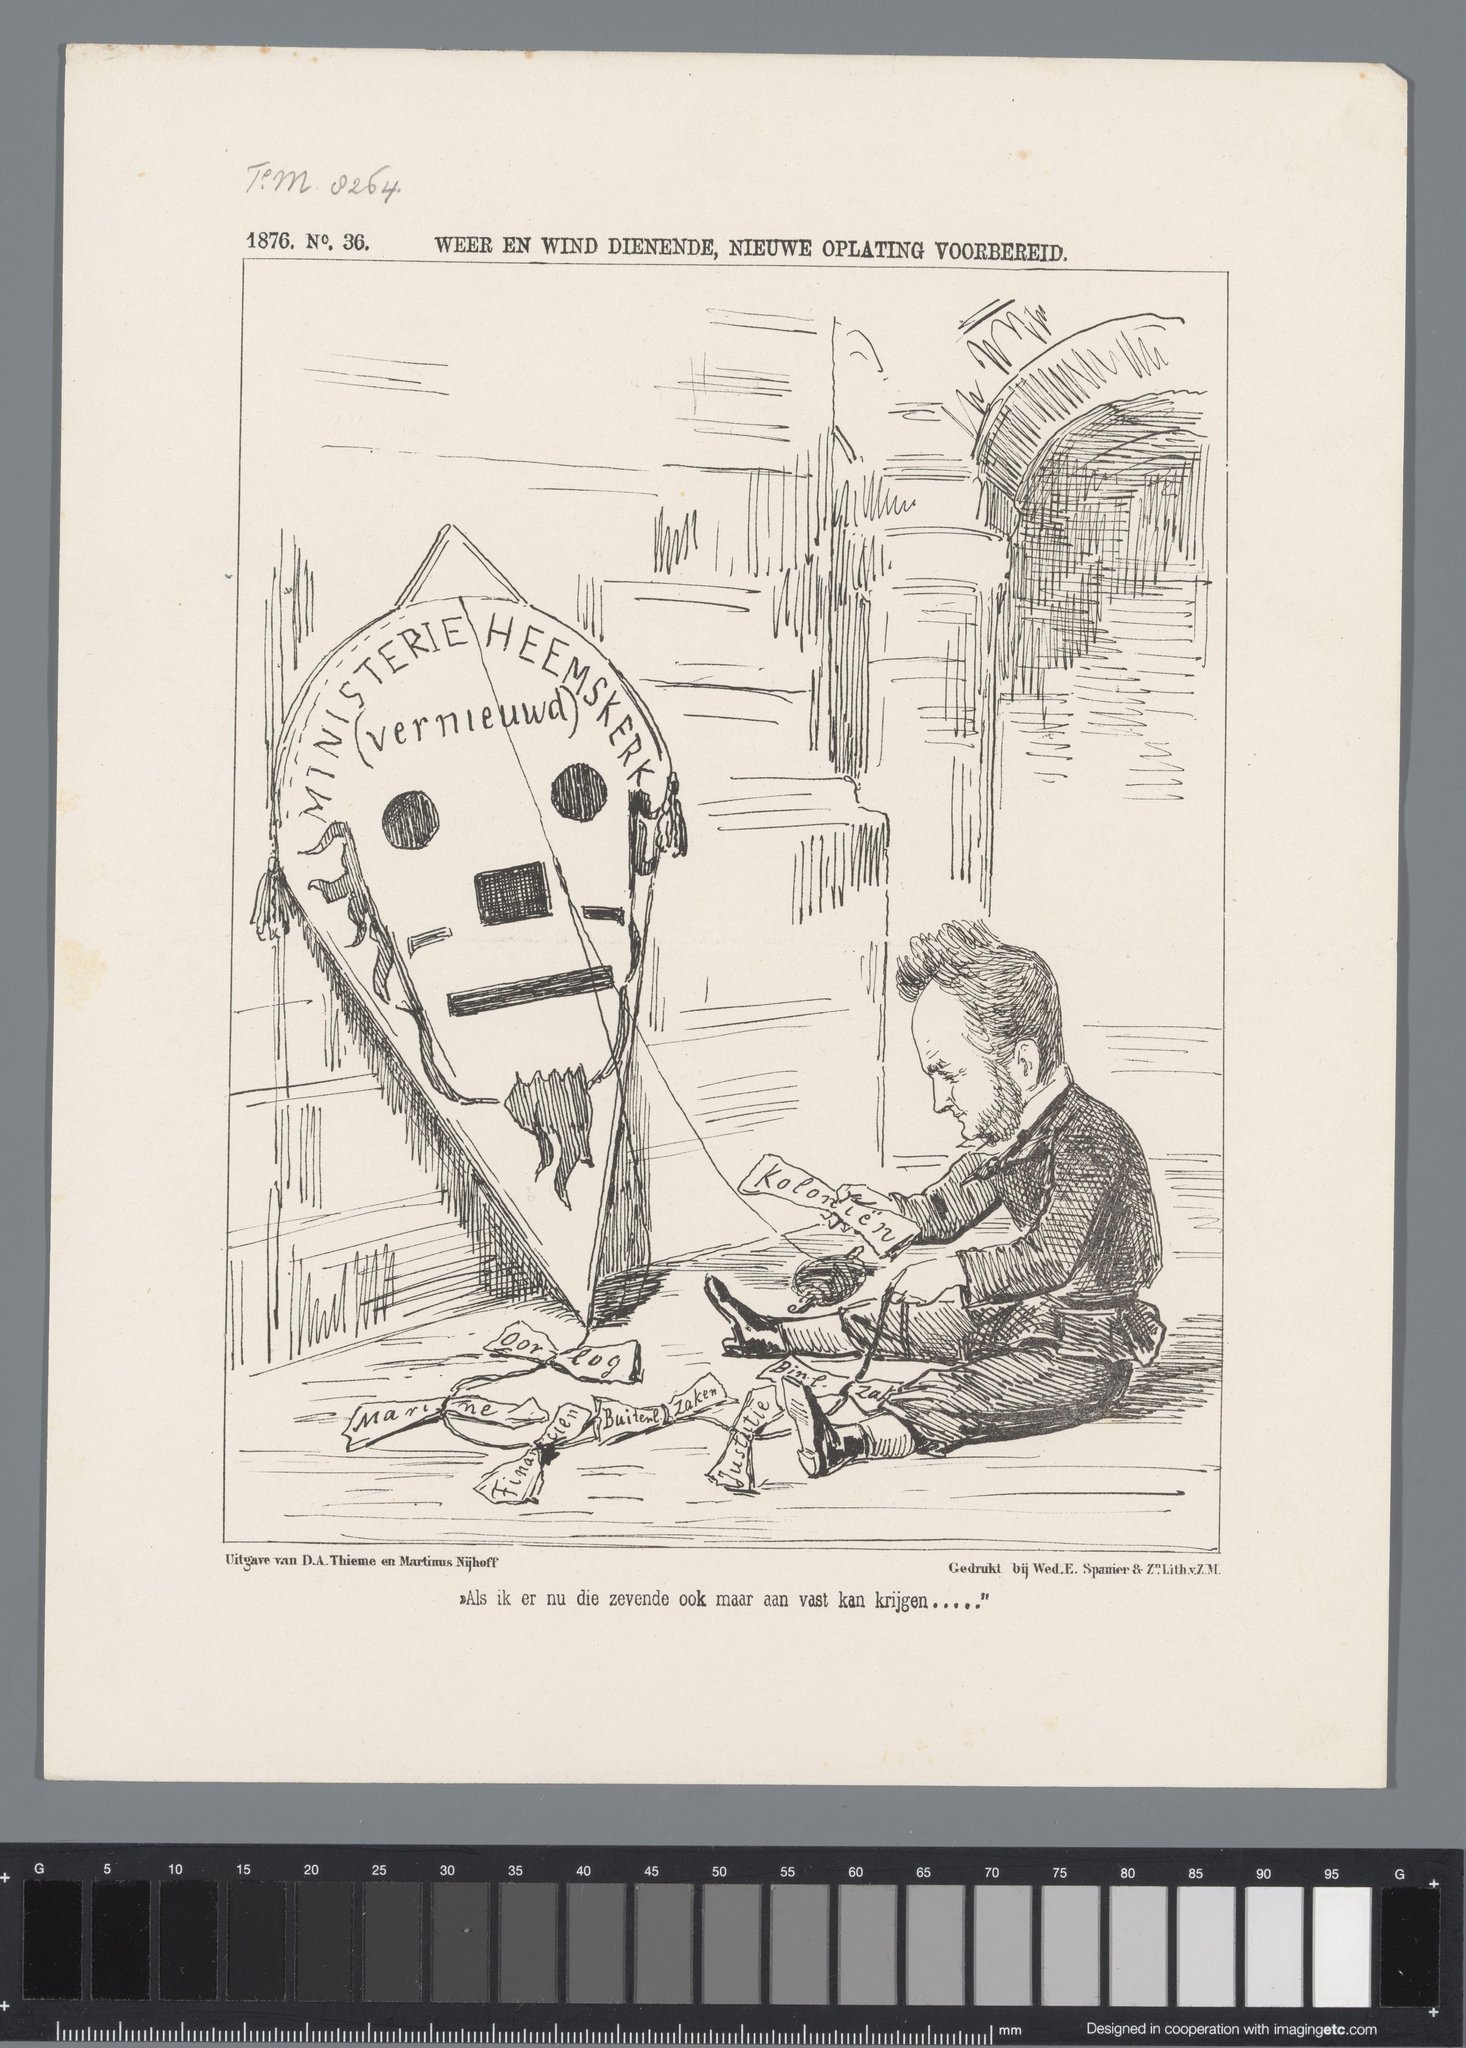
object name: print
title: Allegorie op de hulp aan de getroffenen van de watersnood van maart 1855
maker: alexander ver huell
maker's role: draughtsman, print maker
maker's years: 1822-1897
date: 1855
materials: paper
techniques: tone lithography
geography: netherlands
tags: brussels, willem iii (koning der nederlanden), flood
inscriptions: collector's mark: Lugt 2228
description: Allegorie op de christelijke bereidwilligheid om hulp te verlenen aan de getroffenen van de watersnood van maart en april 1855. Onderaan het door de watersnood getroffen land, met links het bezoek van koning Willem III aan het overstroomde gebied en rechts het bezoek van de koning na het herstel. Een zuil met opschrift 'Liefde' reikt naar de hemel met links en rechts twee engelen. Op de voorgrond een opengeslagen Bijbel en attributen van landbouw, scheepvaart etc.